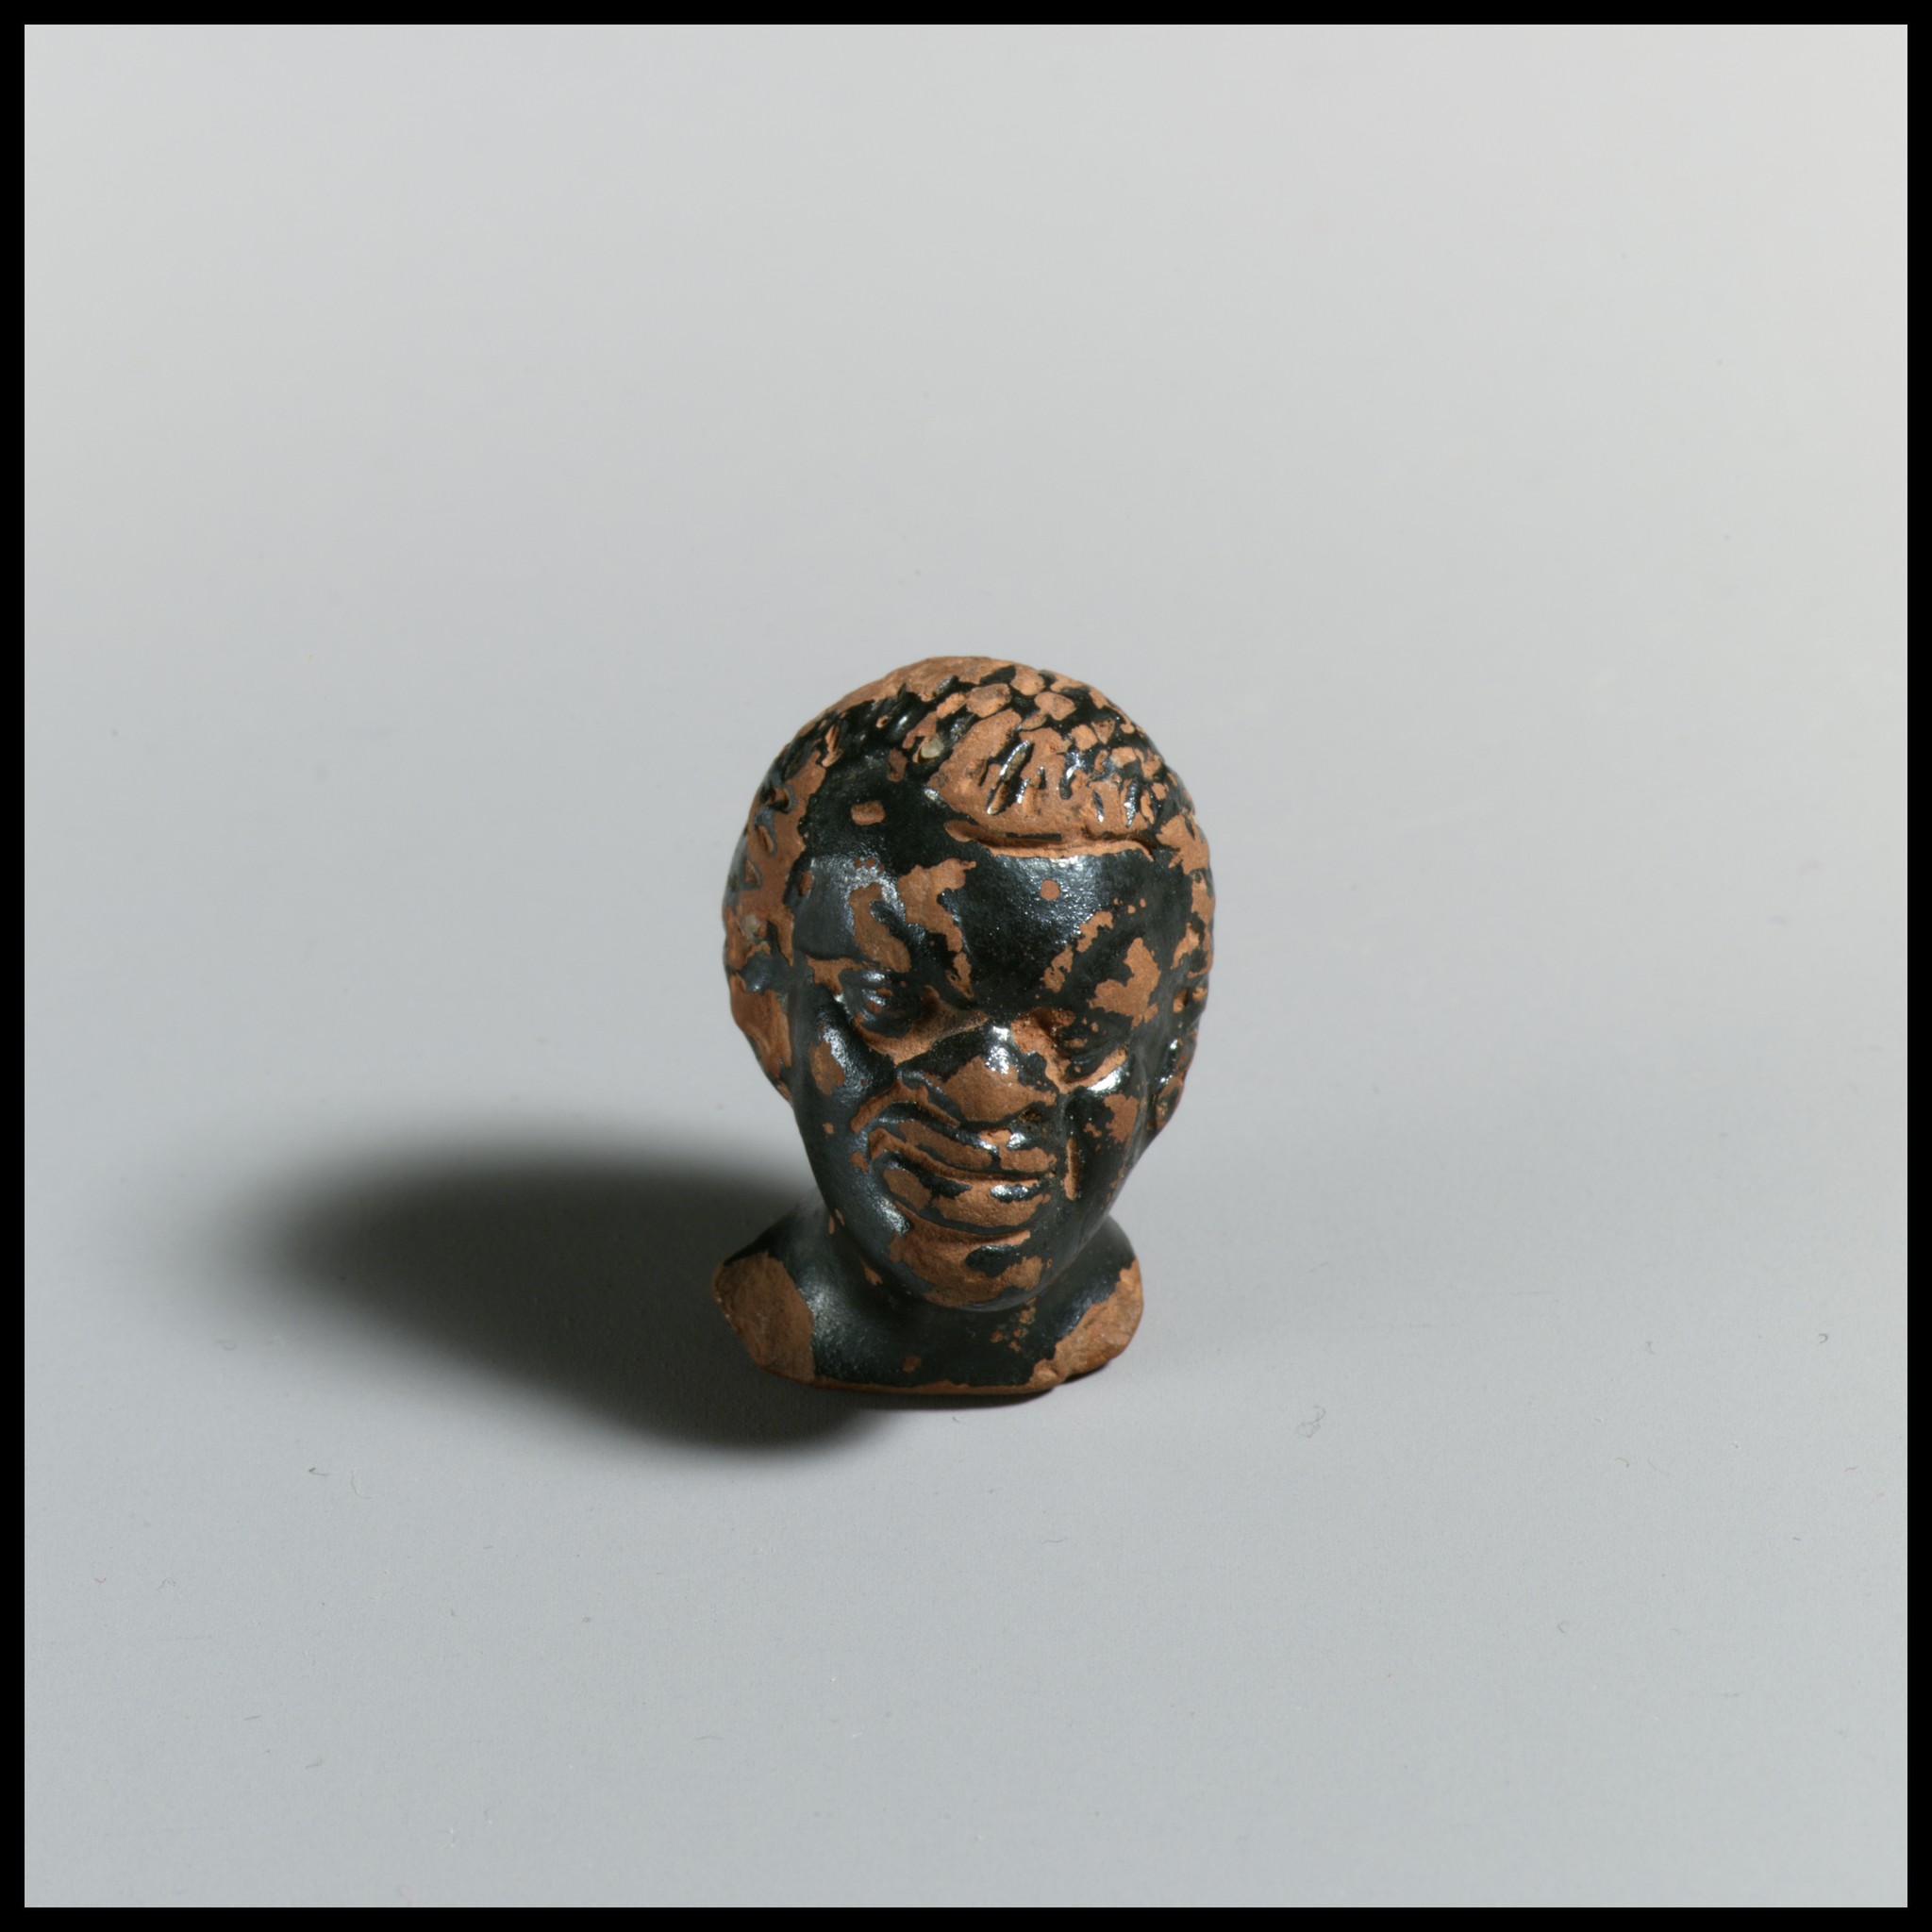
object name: head of a black african man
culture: greek or south italian or campanian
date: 400-301 BCE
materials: terracotta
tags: heads,men